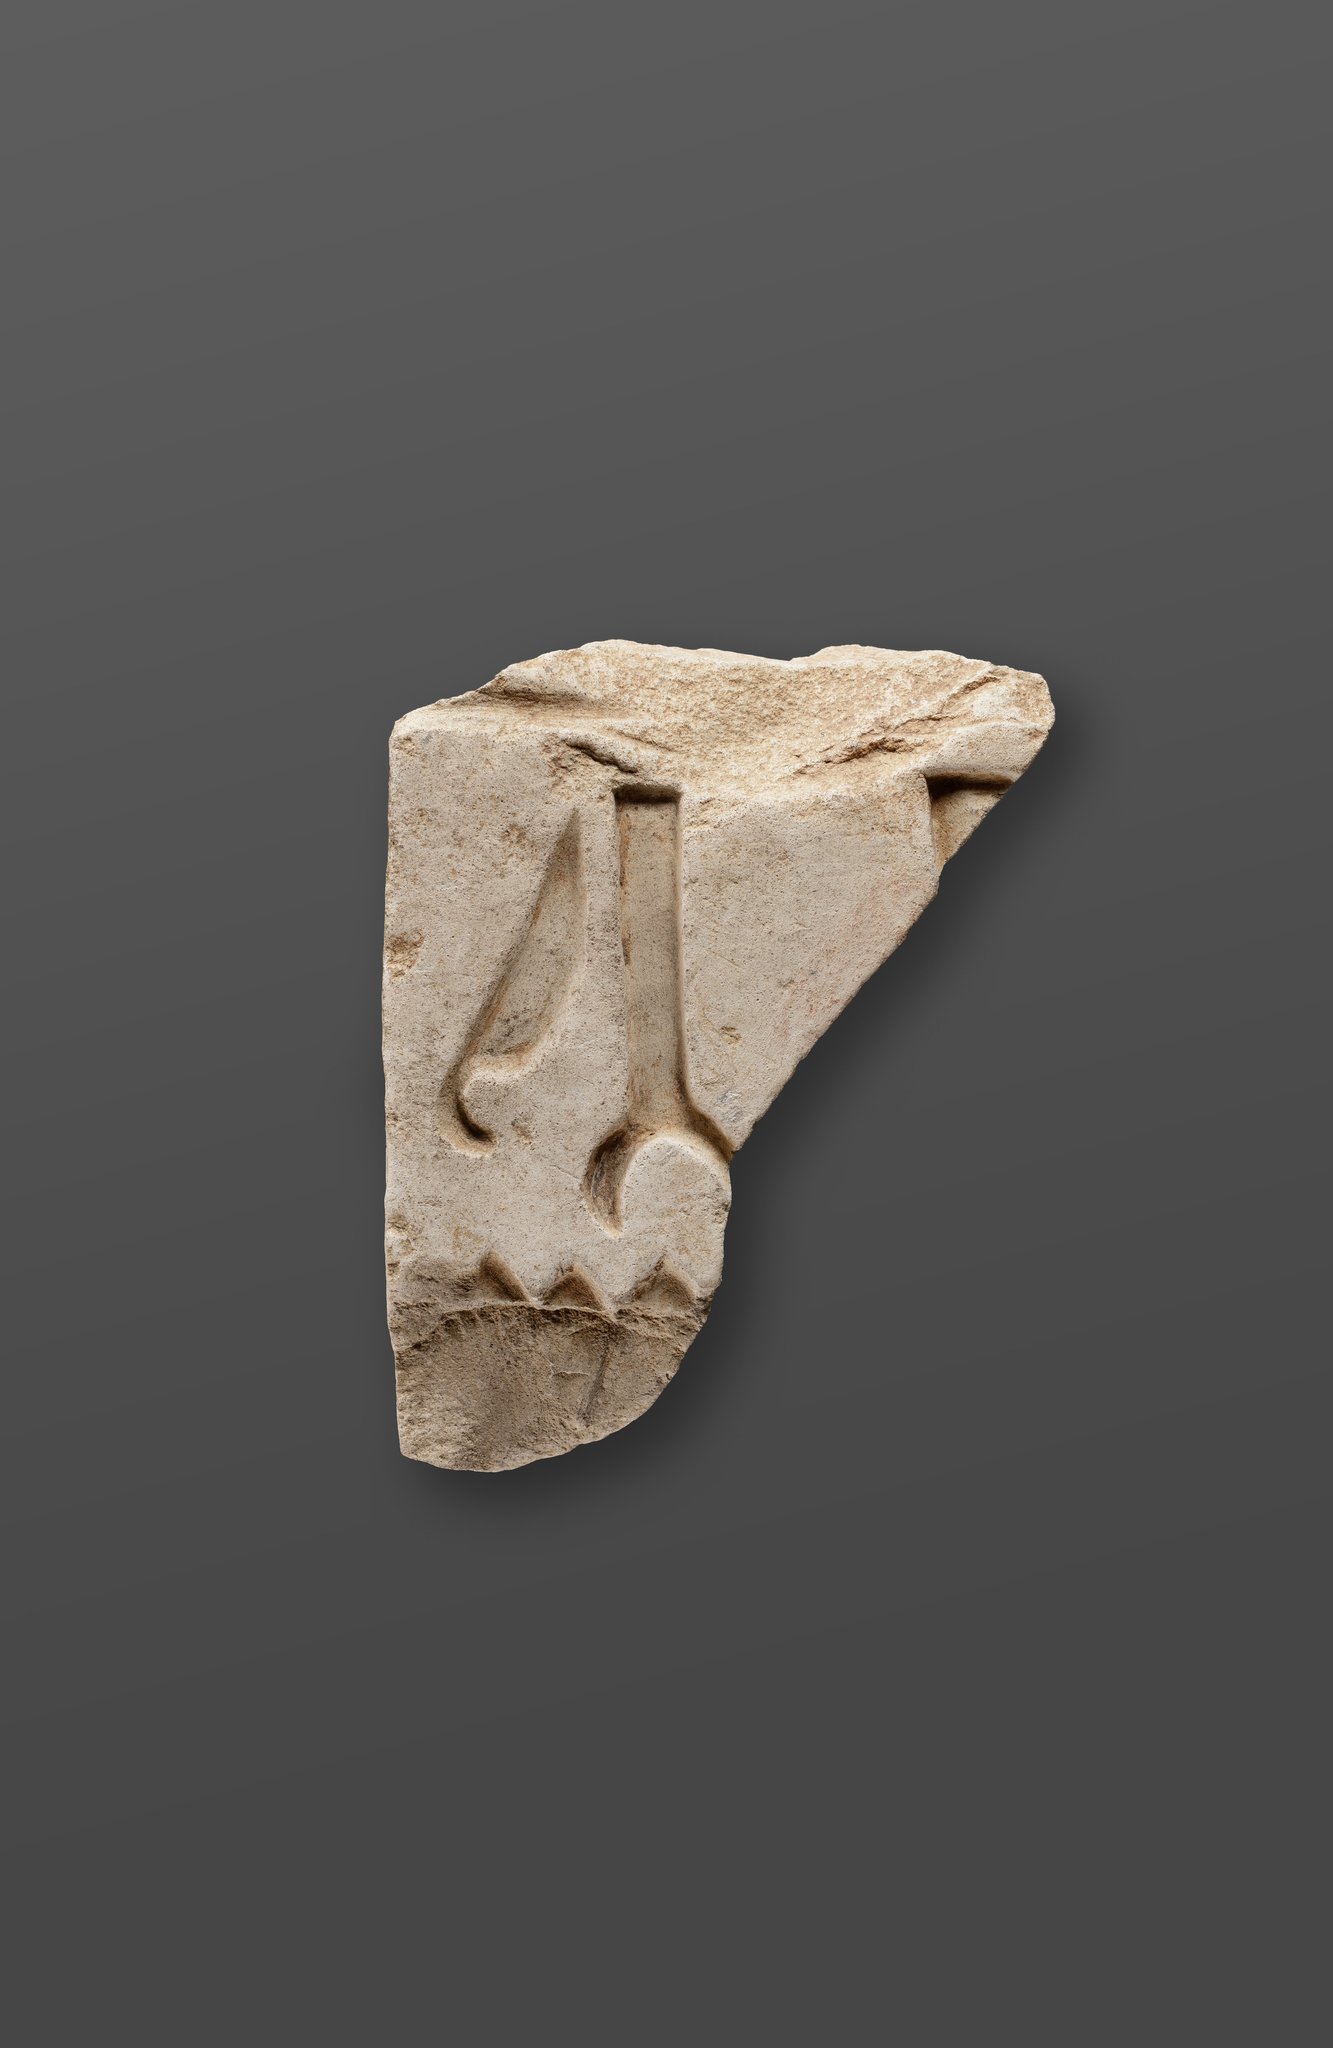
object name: relief fragment, tomb of mereri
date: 2100-2030 BCE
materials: limestone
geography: egypt